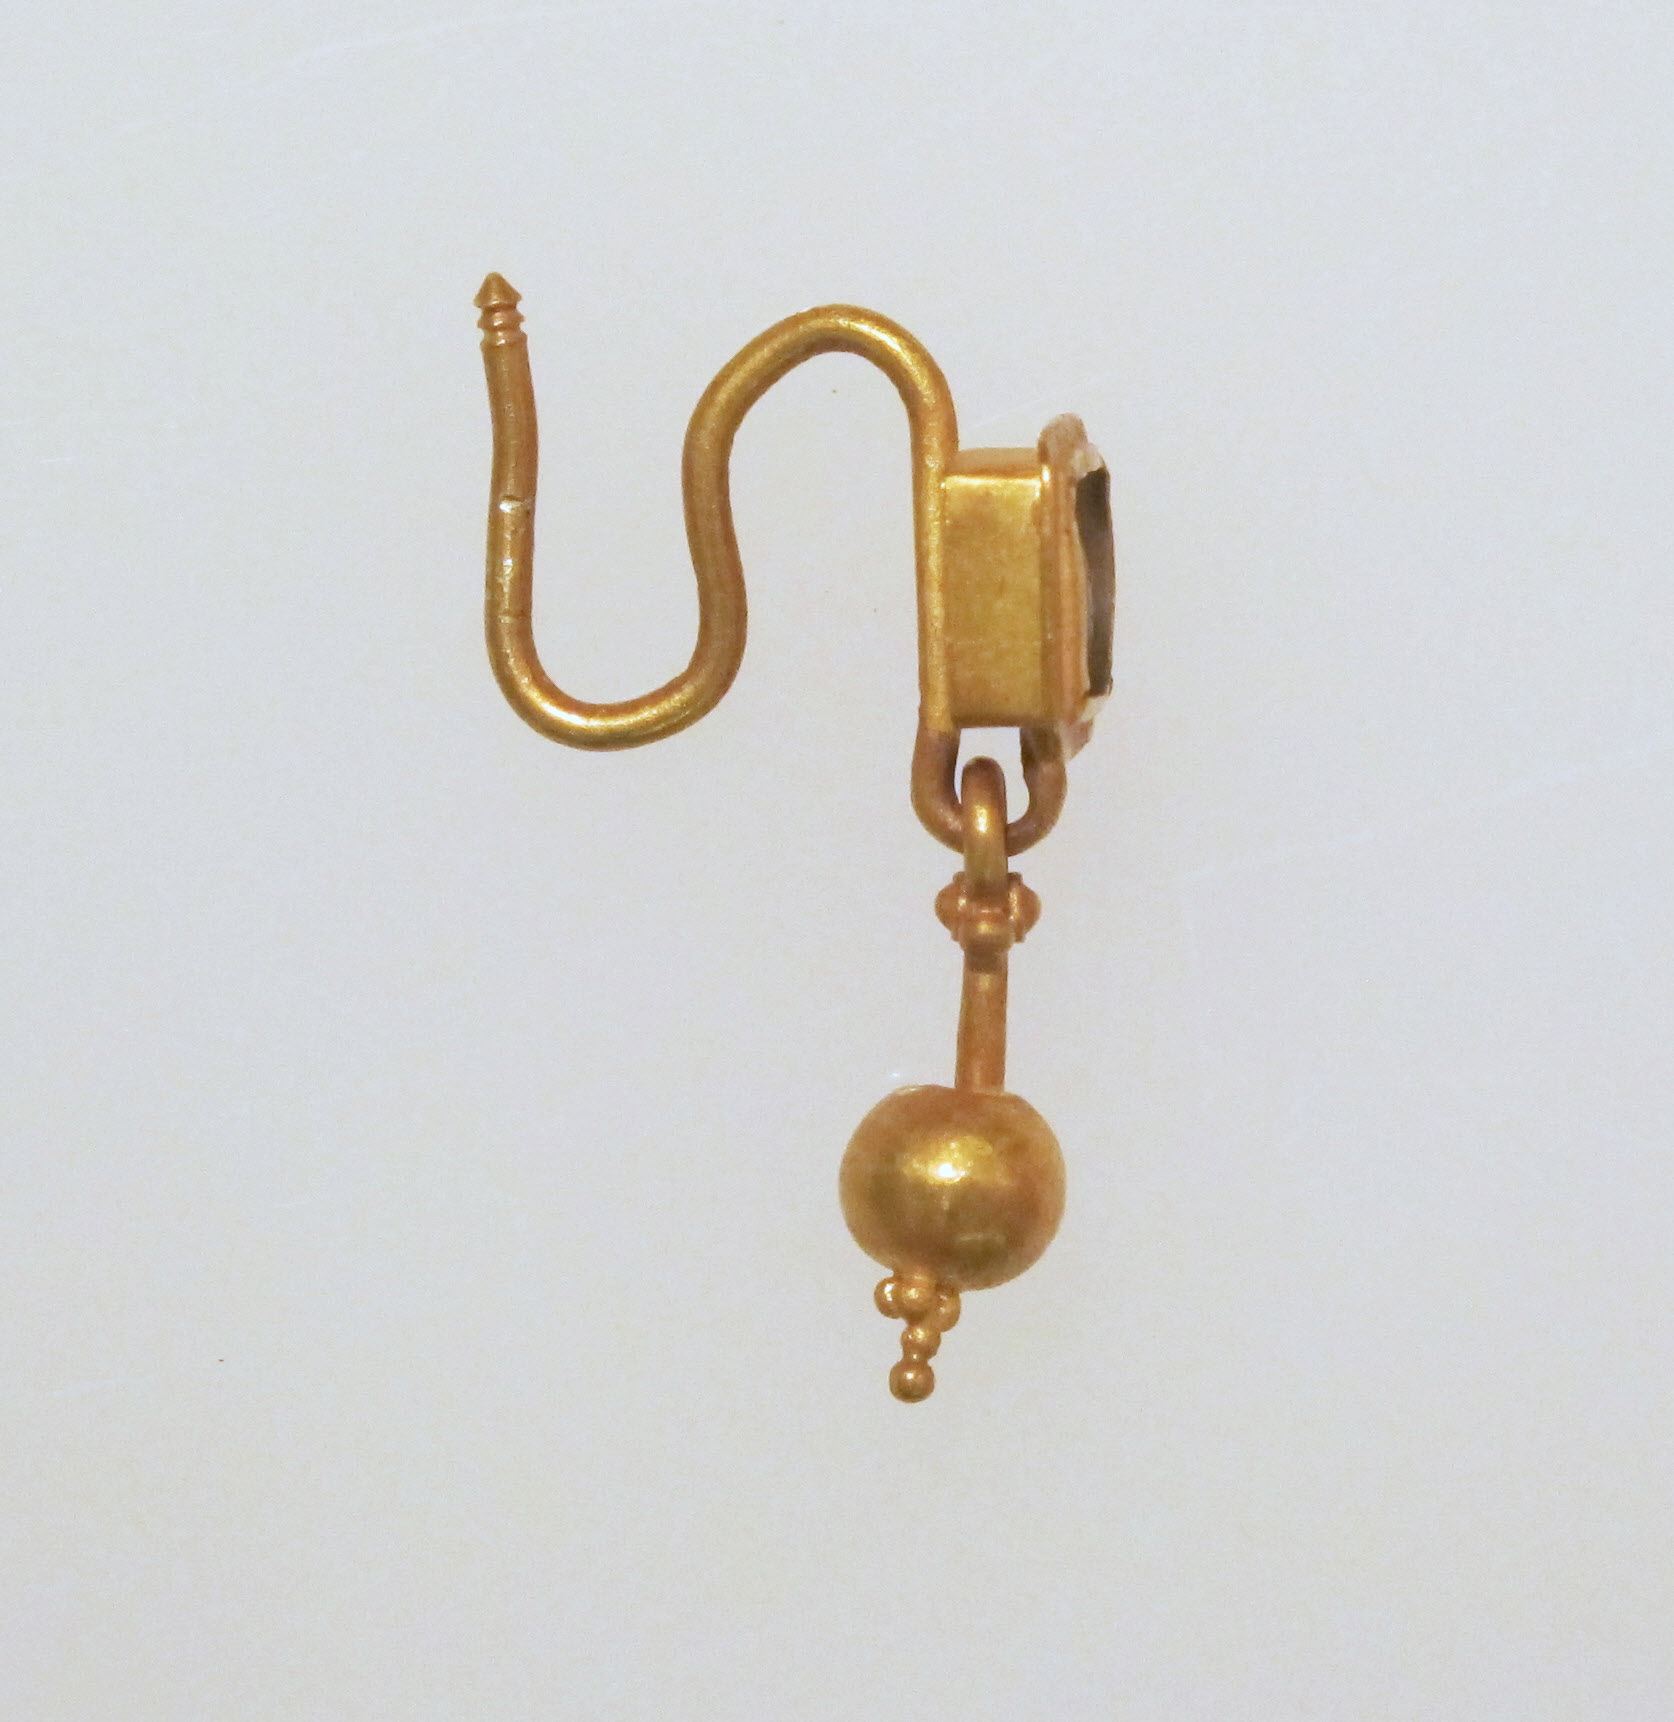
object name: earring hook type with ball pendant and paste setting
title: Earring-hook type with ball pendant and paste setting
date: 7000 BCE-330 CE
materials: glass, gold, paste